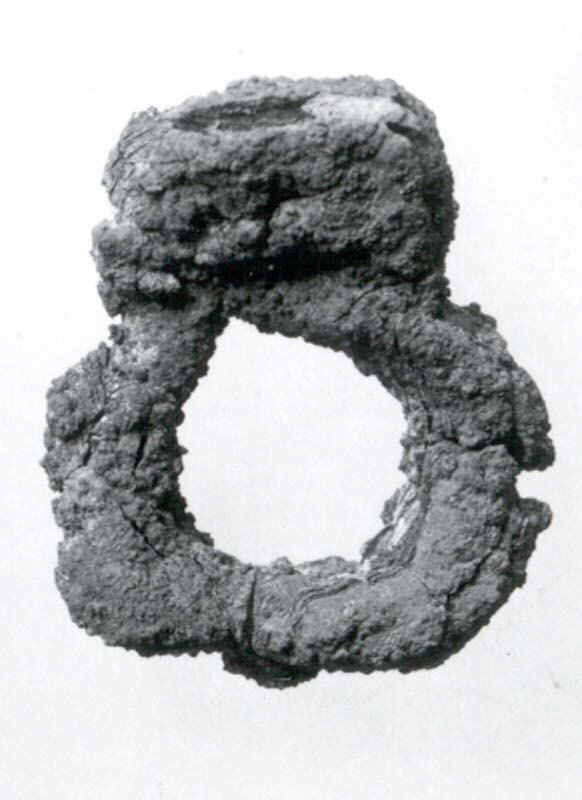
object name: ring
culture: assyrian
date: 900-601 BCE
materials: bronze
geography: mesopotamia